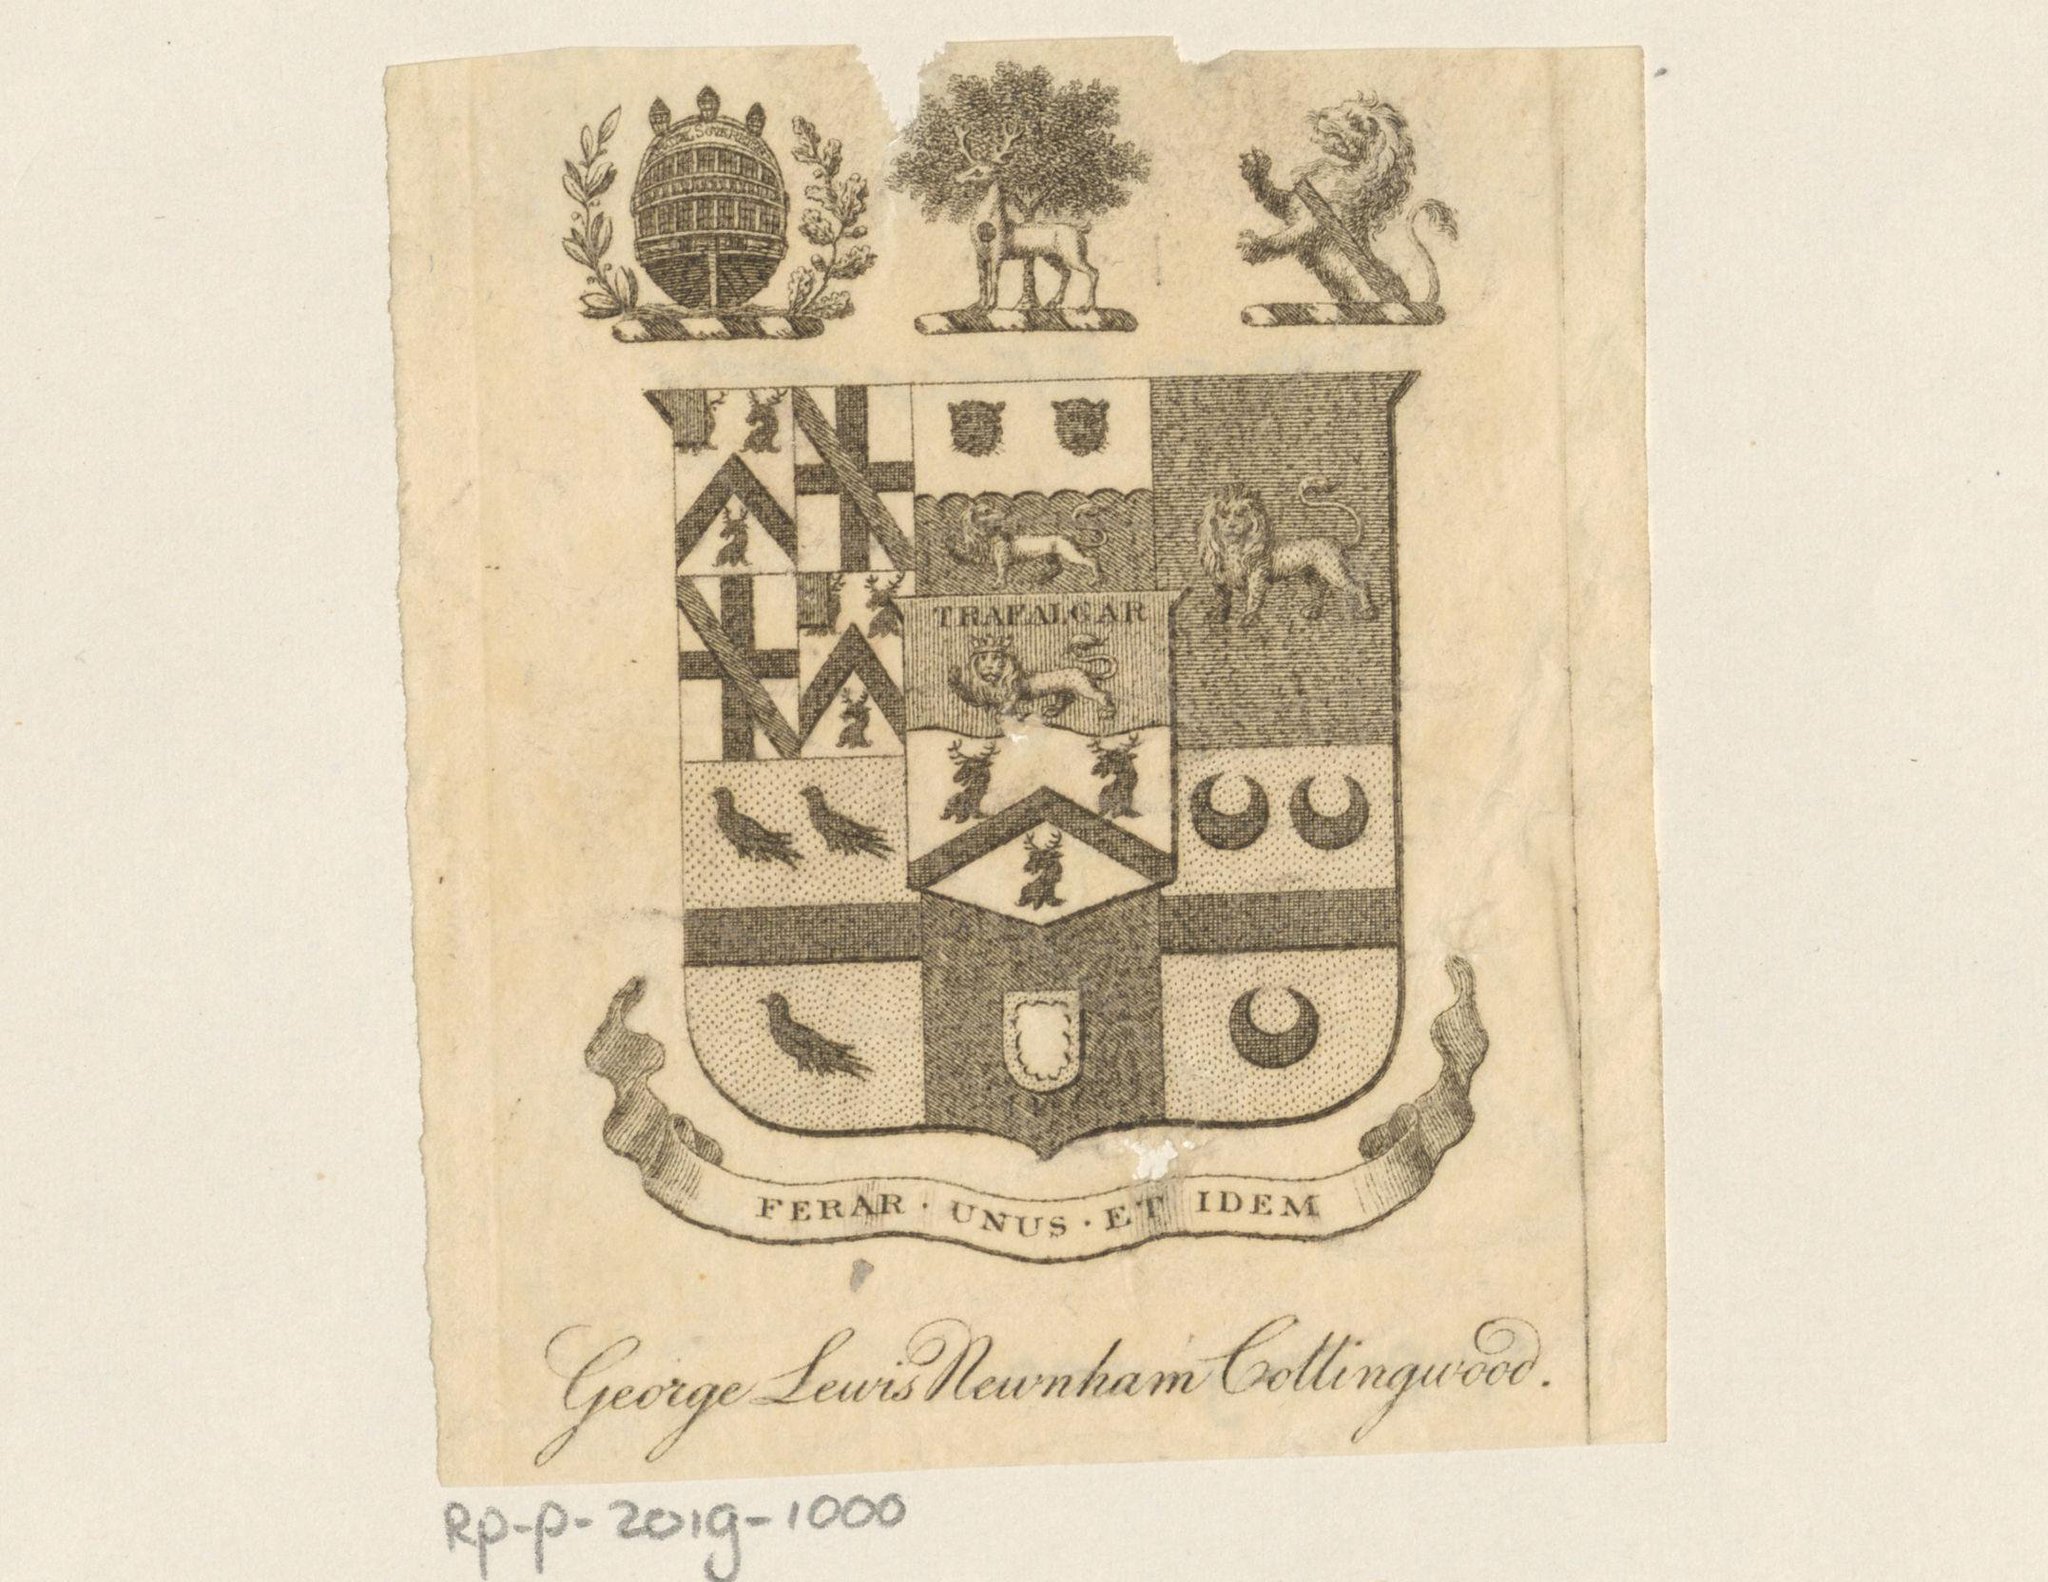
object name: bookplate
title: Ferar unus et idem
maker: Anonymous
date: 1792-1837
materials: paper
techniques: etching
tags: armorial bearing, heraldry